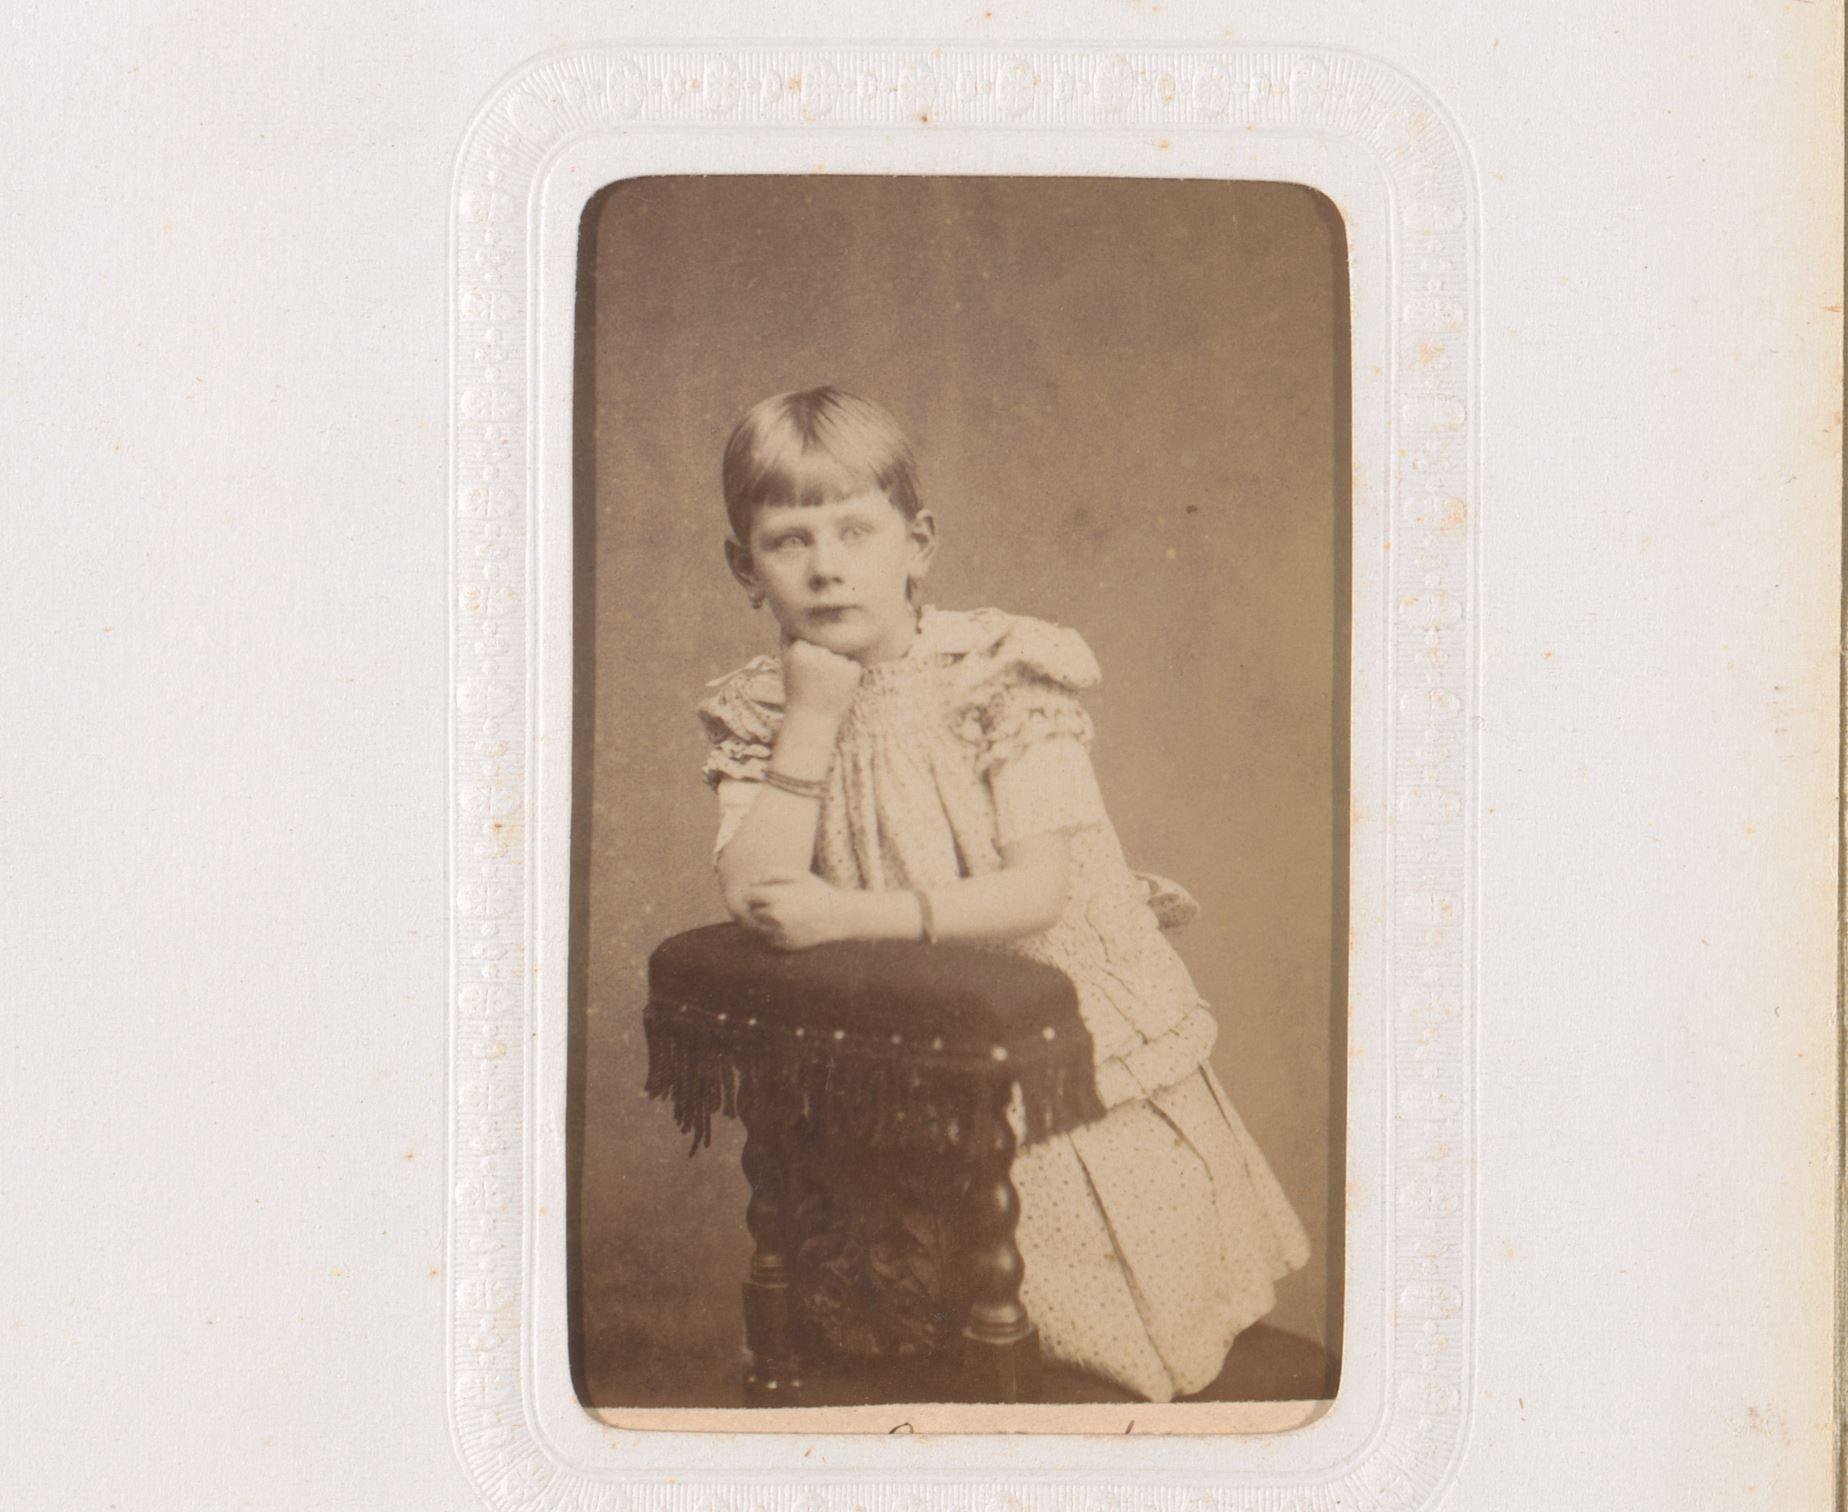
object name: photograph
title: Portret van een meisje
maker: gilles johannis van den berge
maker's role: fotograaf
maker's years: 1847-1924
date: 1867-1898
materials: cardboard, photographic support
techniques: albumen print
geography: deventer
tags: girl (child between toddler and youth)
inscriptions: annotation: ‘Geboren 25/5 81/ 8/87.-’